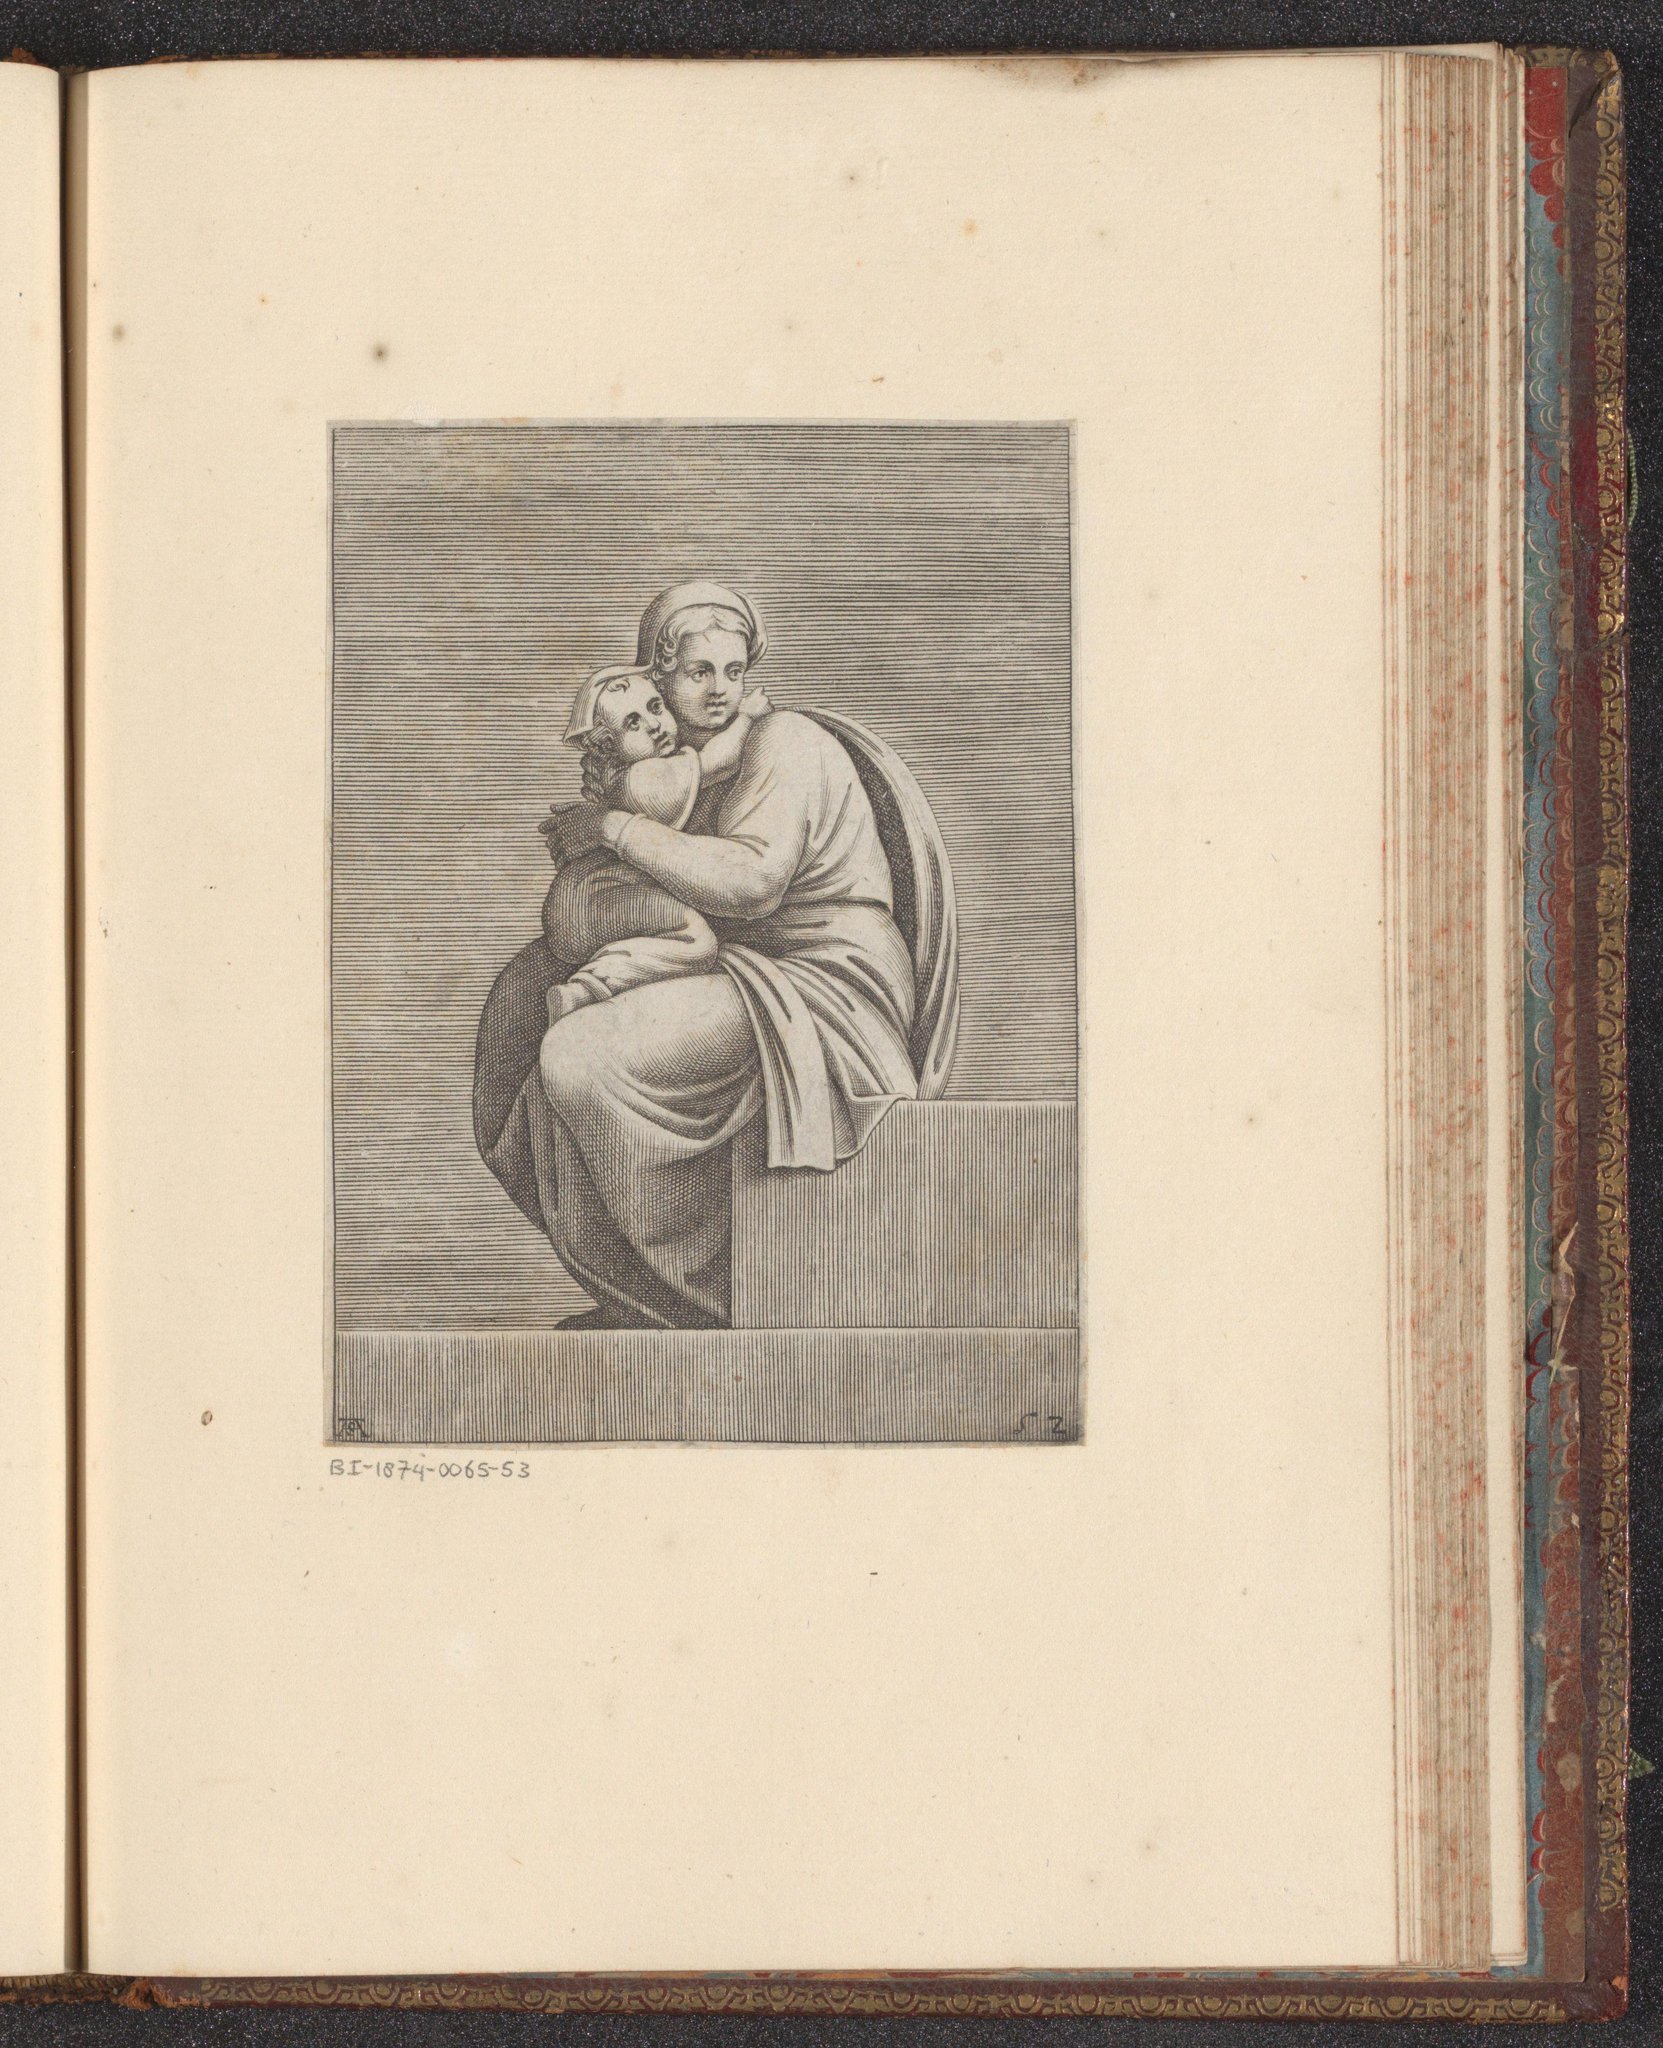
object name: print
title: Zittende vrouw met kind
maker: adamo scultori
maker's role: painter, print maker, sculptor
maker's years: 1530-1585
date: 1585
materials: paper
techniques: engraving, intaglio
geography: italy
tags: mother and child(ren), woman and child(ren) (family group)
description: Deze prent maakt deel uit van een serie bestaande uit een titelprent en 72 prenten naar schilderingen door Michelangelo in de Sixtijnse Kapel in het Vaticaan.